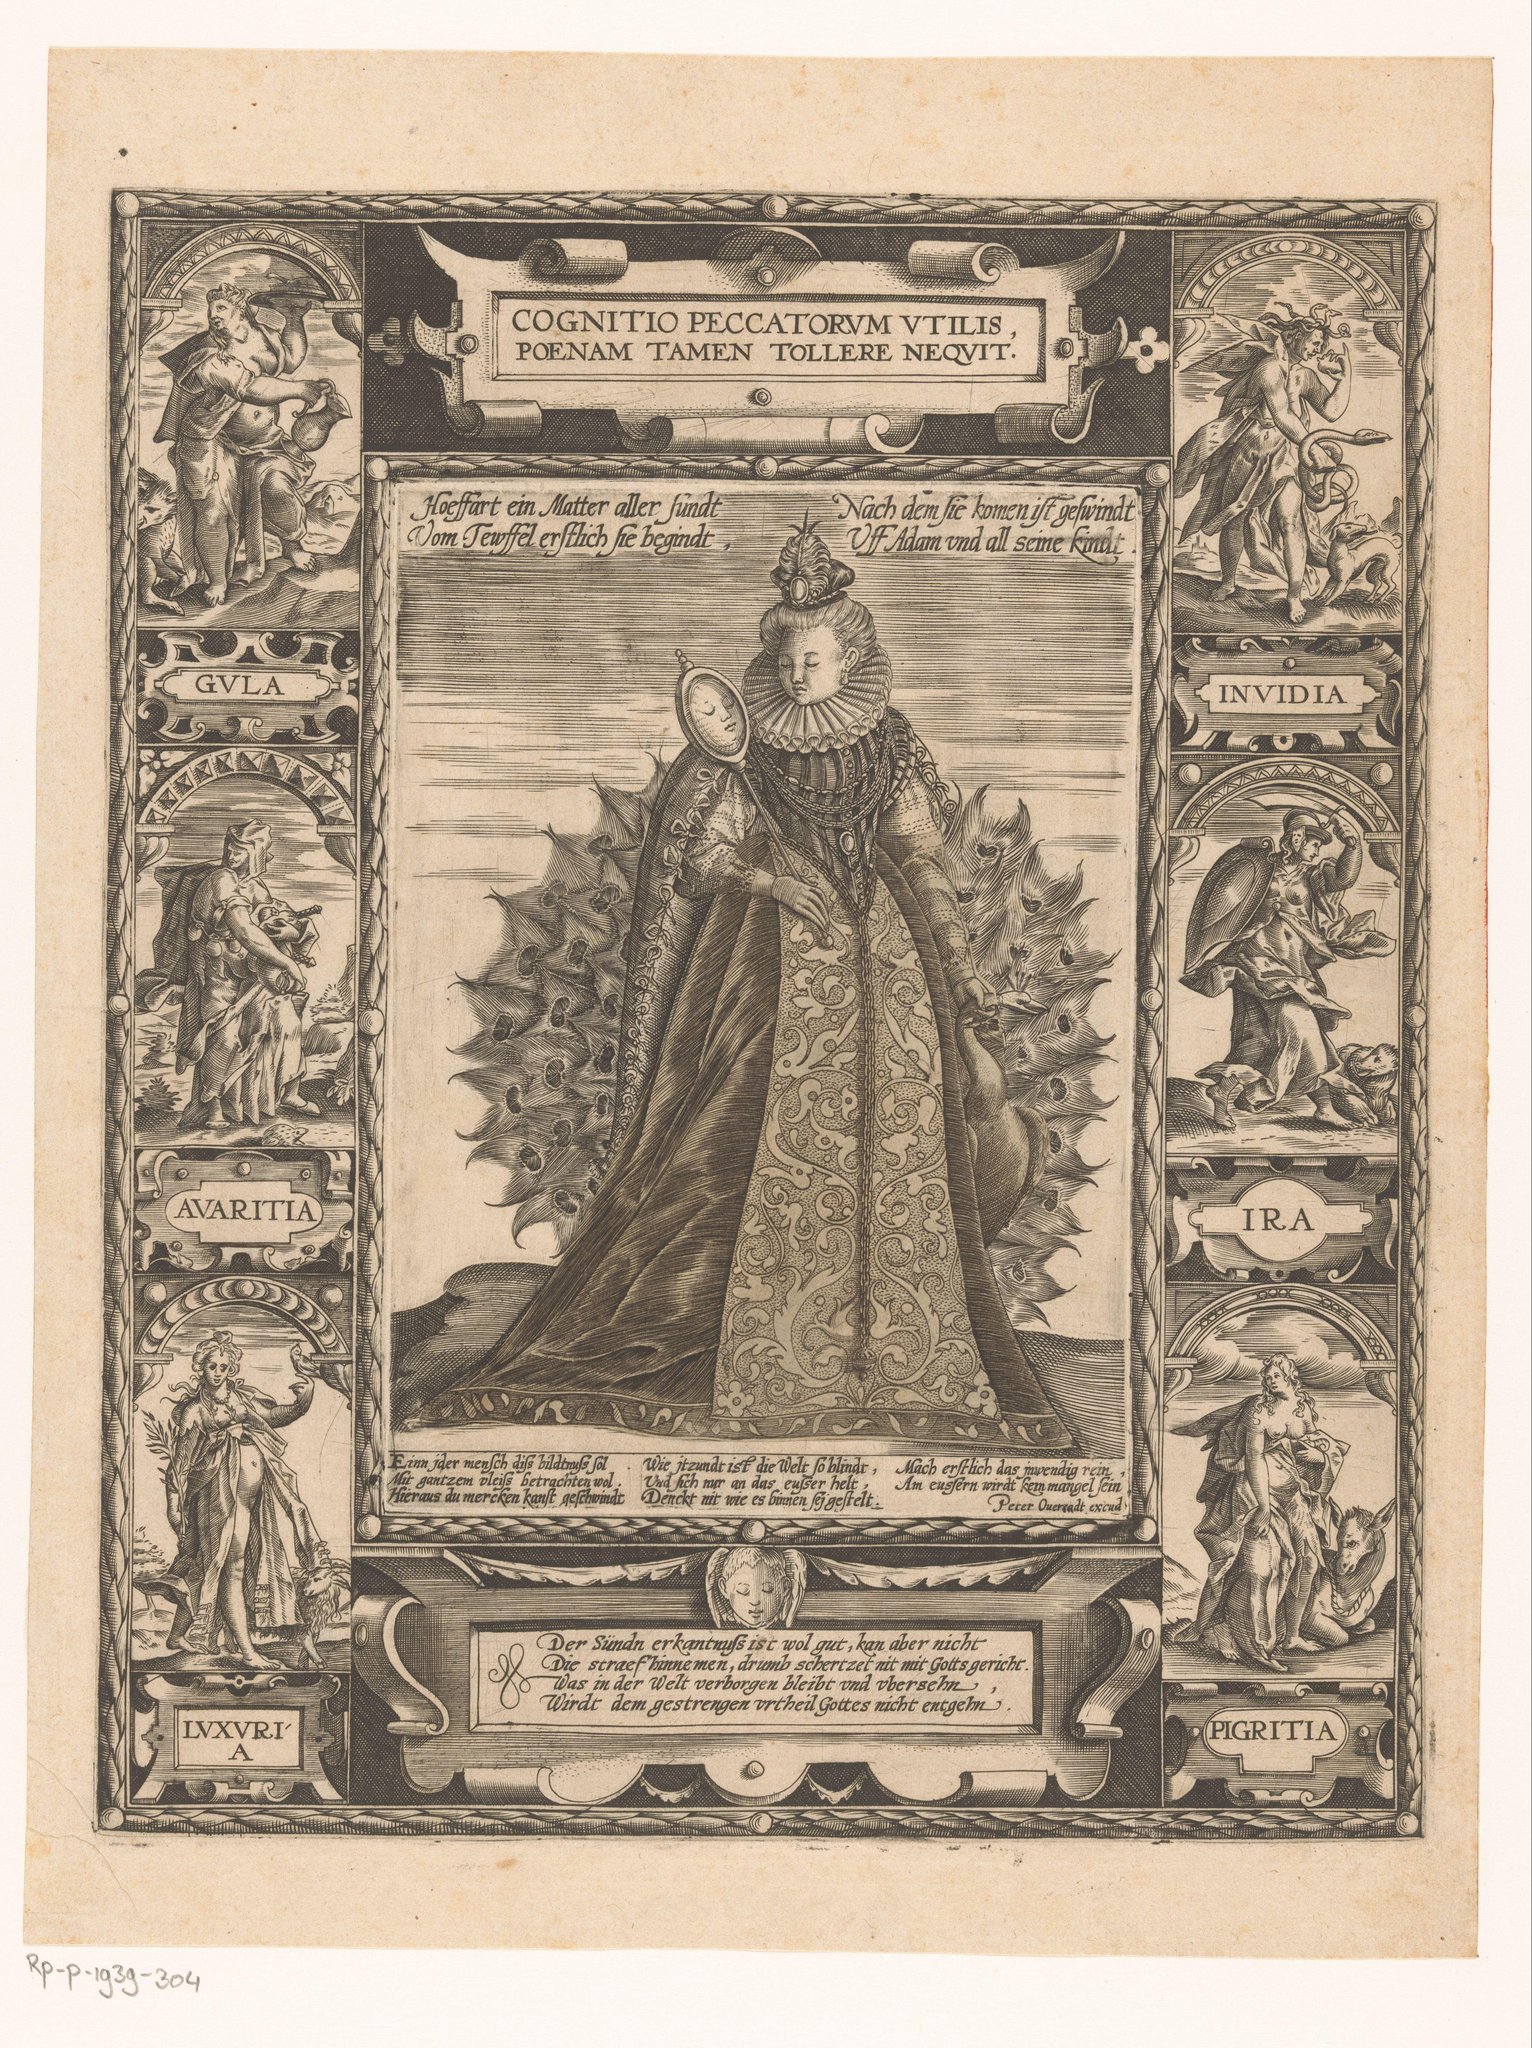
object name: print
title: Cognitio peccatorum utilis, poenam tamen tollere nequit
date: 1578-1597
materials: paper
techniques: engraving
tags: looking in the mirror; (possibly: contemplation of own beauty - aa - (for) women), envy; 'invidia' (ripa) ~ personification of one of the seven deadly sins, neck-gear: collar (+ women's clothes), head-gear: hat (+ women's clothes), dress, gown (+ women's clothes), ornamental birds: peacock, the seven deadly sins (personified), eve takes the fruit from the serpent (or the tree) in the presence of adam (who may be trying to stop her)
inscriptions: collector's mark: Lugt 2760, collector's mark: Lugt 2228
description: Superbia als modieus geklede dame, spiegel in de rechterhand, haar linkerhand rustend op de kop van de pauw, haar attribuut. De rok van de japon is opklapbaar. Hieronder haar onderlijf als skelet met Adam en Eva tijdens de zondeval. In omlijsting waarin de personificaties van de andere zes hoofdzonden zijn afgebeeld: Gula, Avaritia, Luxuria, Invidia, Ira, Pigritia. Titel in cartouche middenboven. Met opschrift: Hoeffart ein Matter aller Sundt [...] all sein Kindt. Als onderschrift een 8-regelig vers in het Duits. Middenonder in cartouche een vierregelig vers: Der Sündn erkantnuss ist wol gut, kan aber nicht [...] urtheil Gottes nicht entgehn.